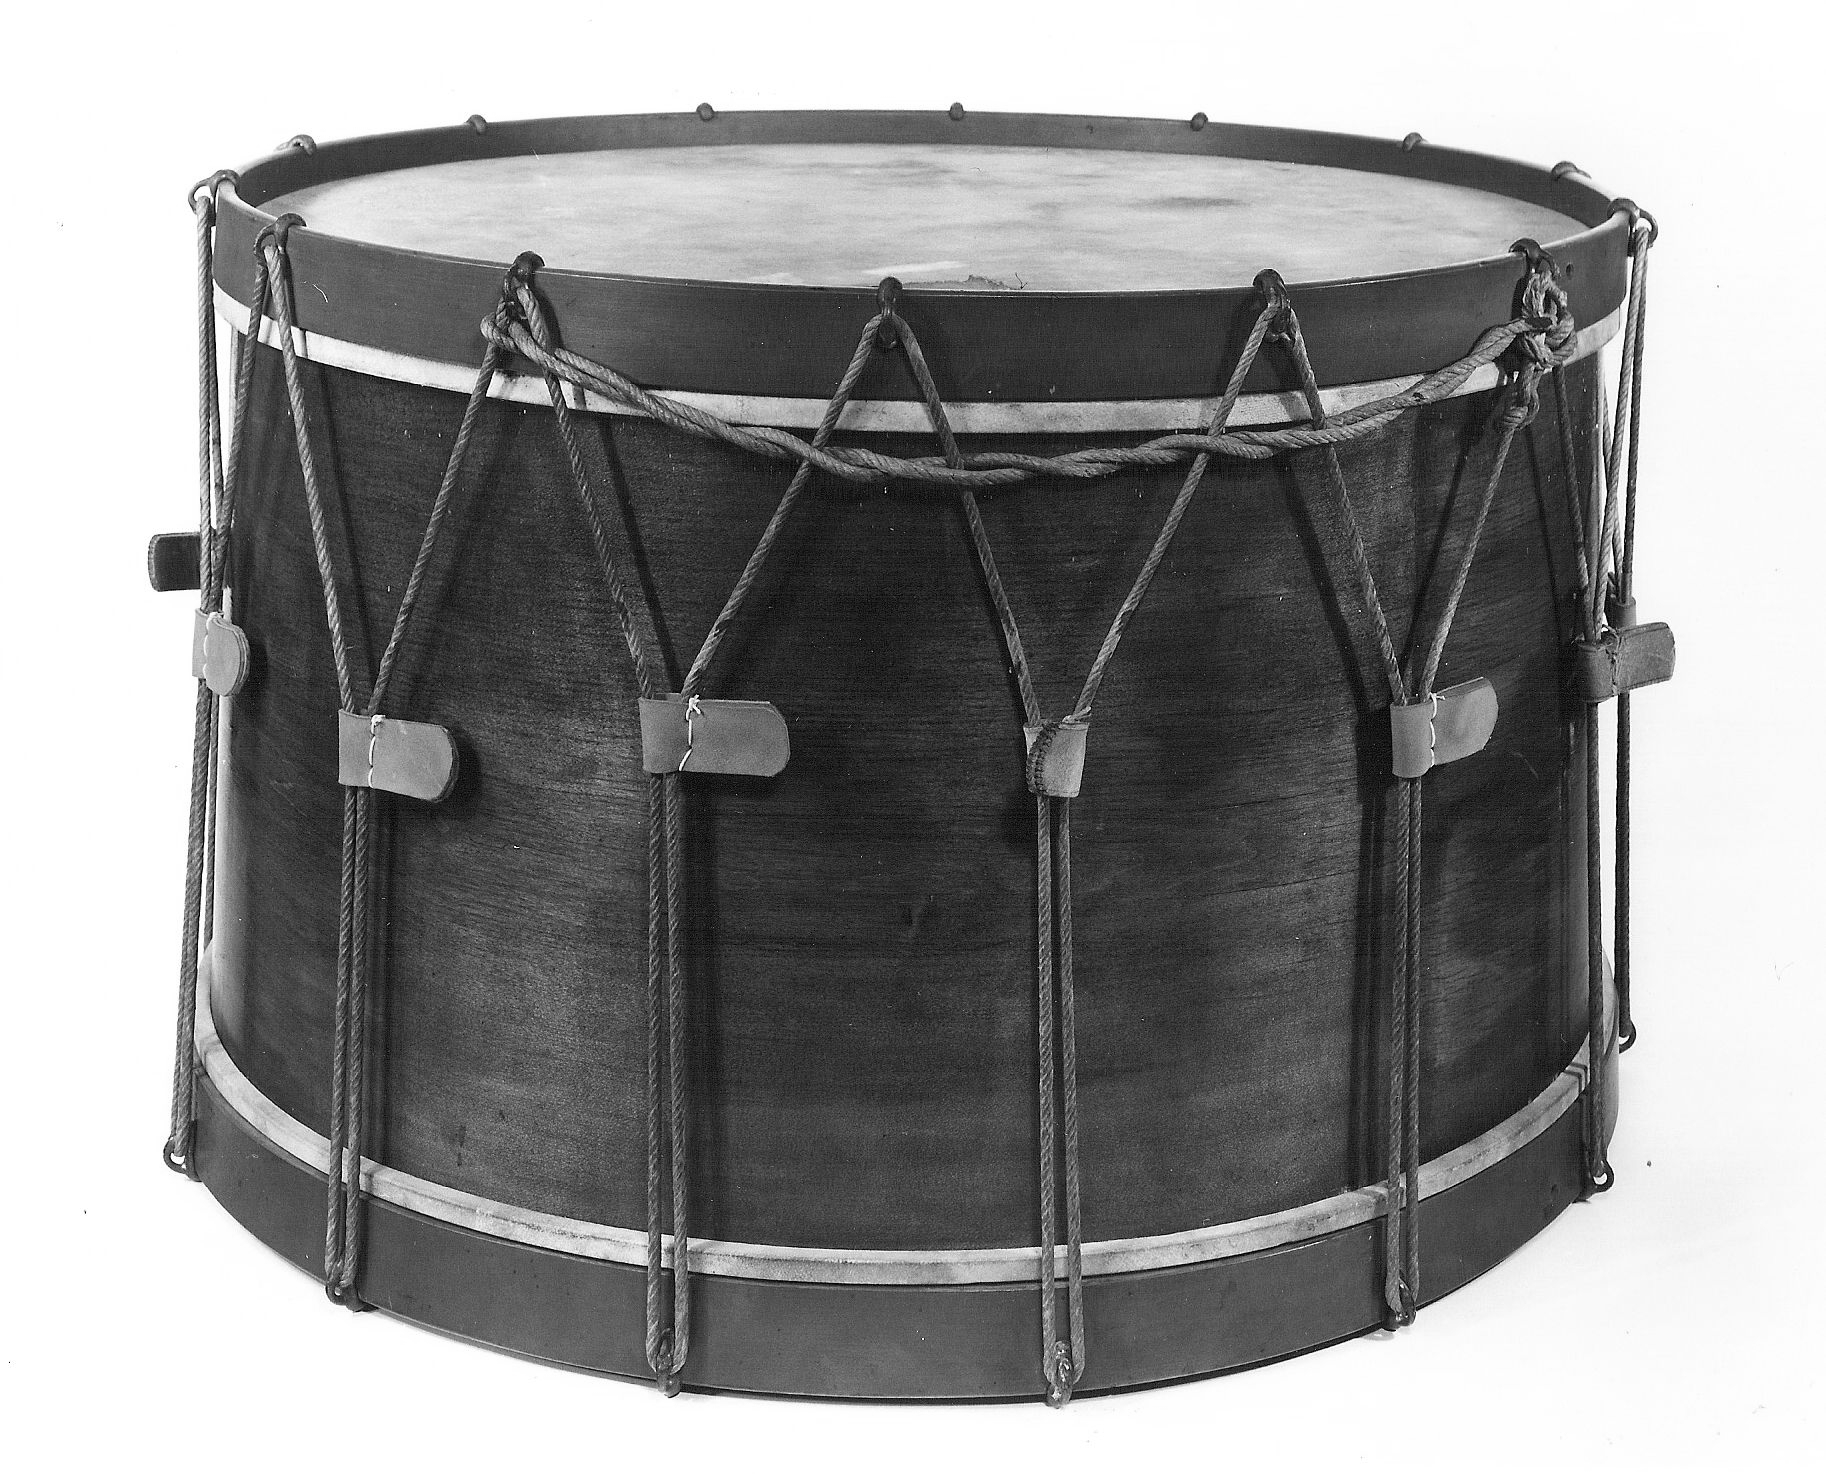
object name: bass drum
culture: american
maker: john g. pike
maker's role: maker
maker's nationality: american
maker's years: 1815-1884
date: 1860-1880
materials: leather, metal, parchment, wood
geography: united states